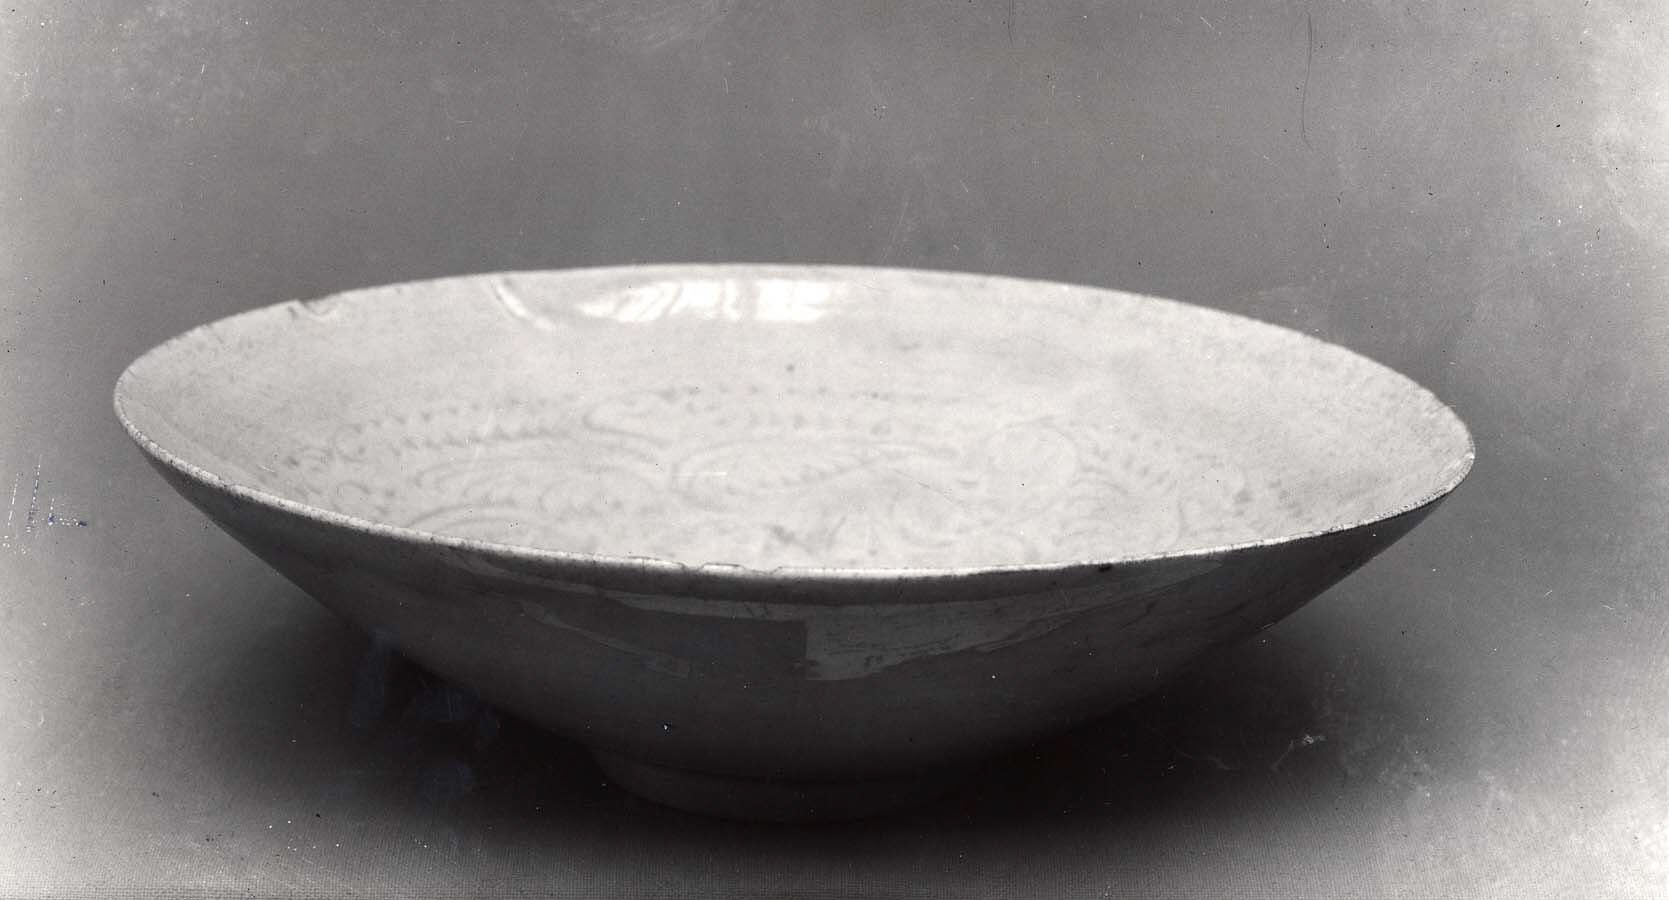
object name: bowl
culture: korean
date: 918-1392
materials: pottery